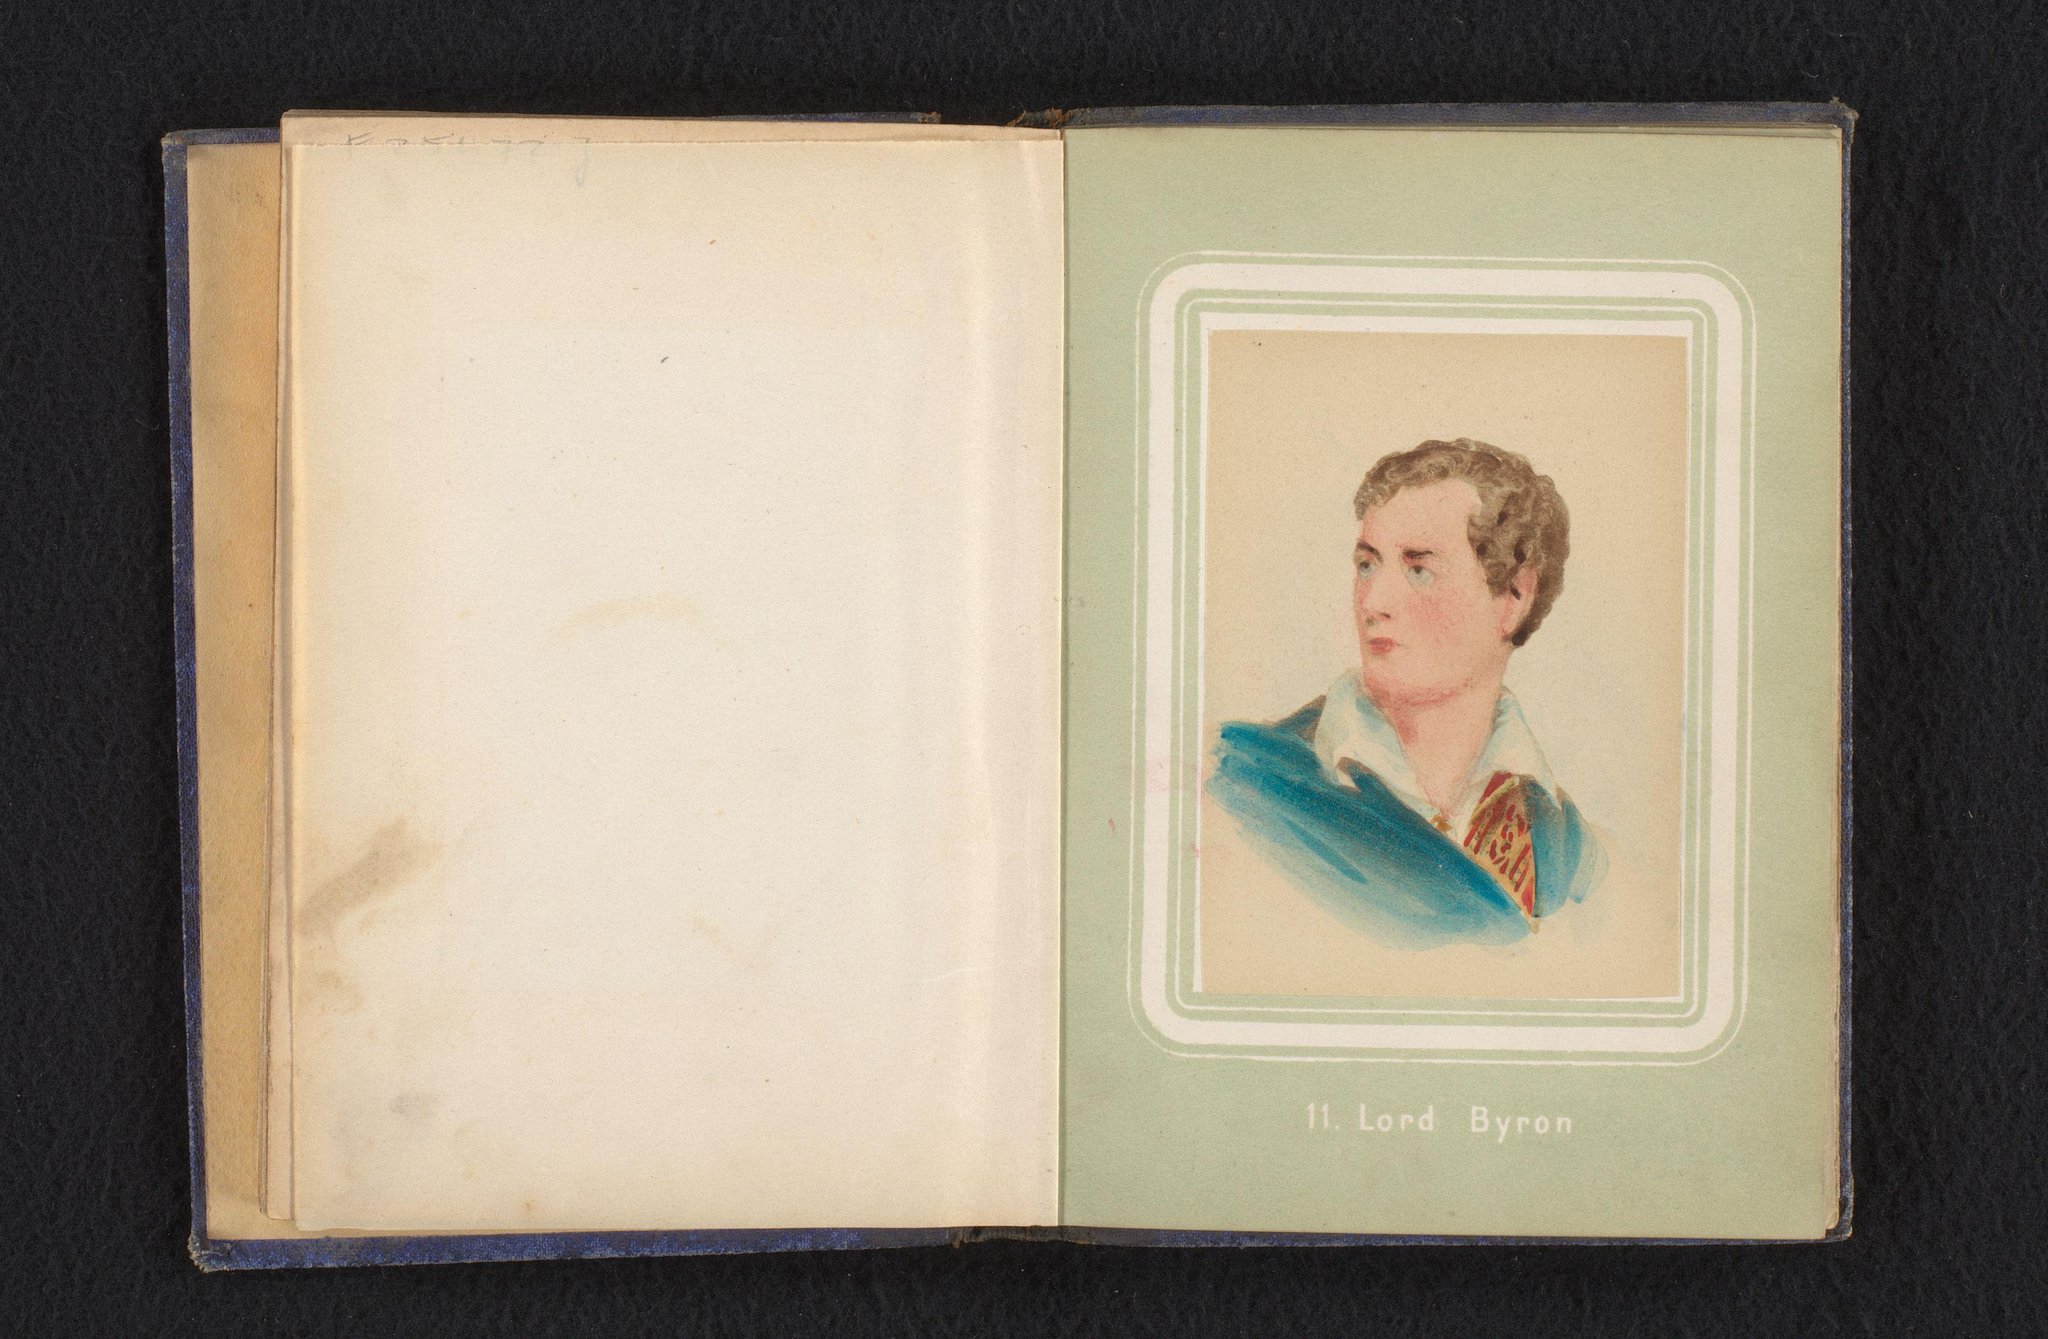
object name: page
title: Lord Byron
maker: Anonymous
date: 1870-1890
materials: paper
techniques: albumen print, hand coloring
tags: london, lord byron, historical persons, portrait of a writer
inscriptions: number: ‘11.’